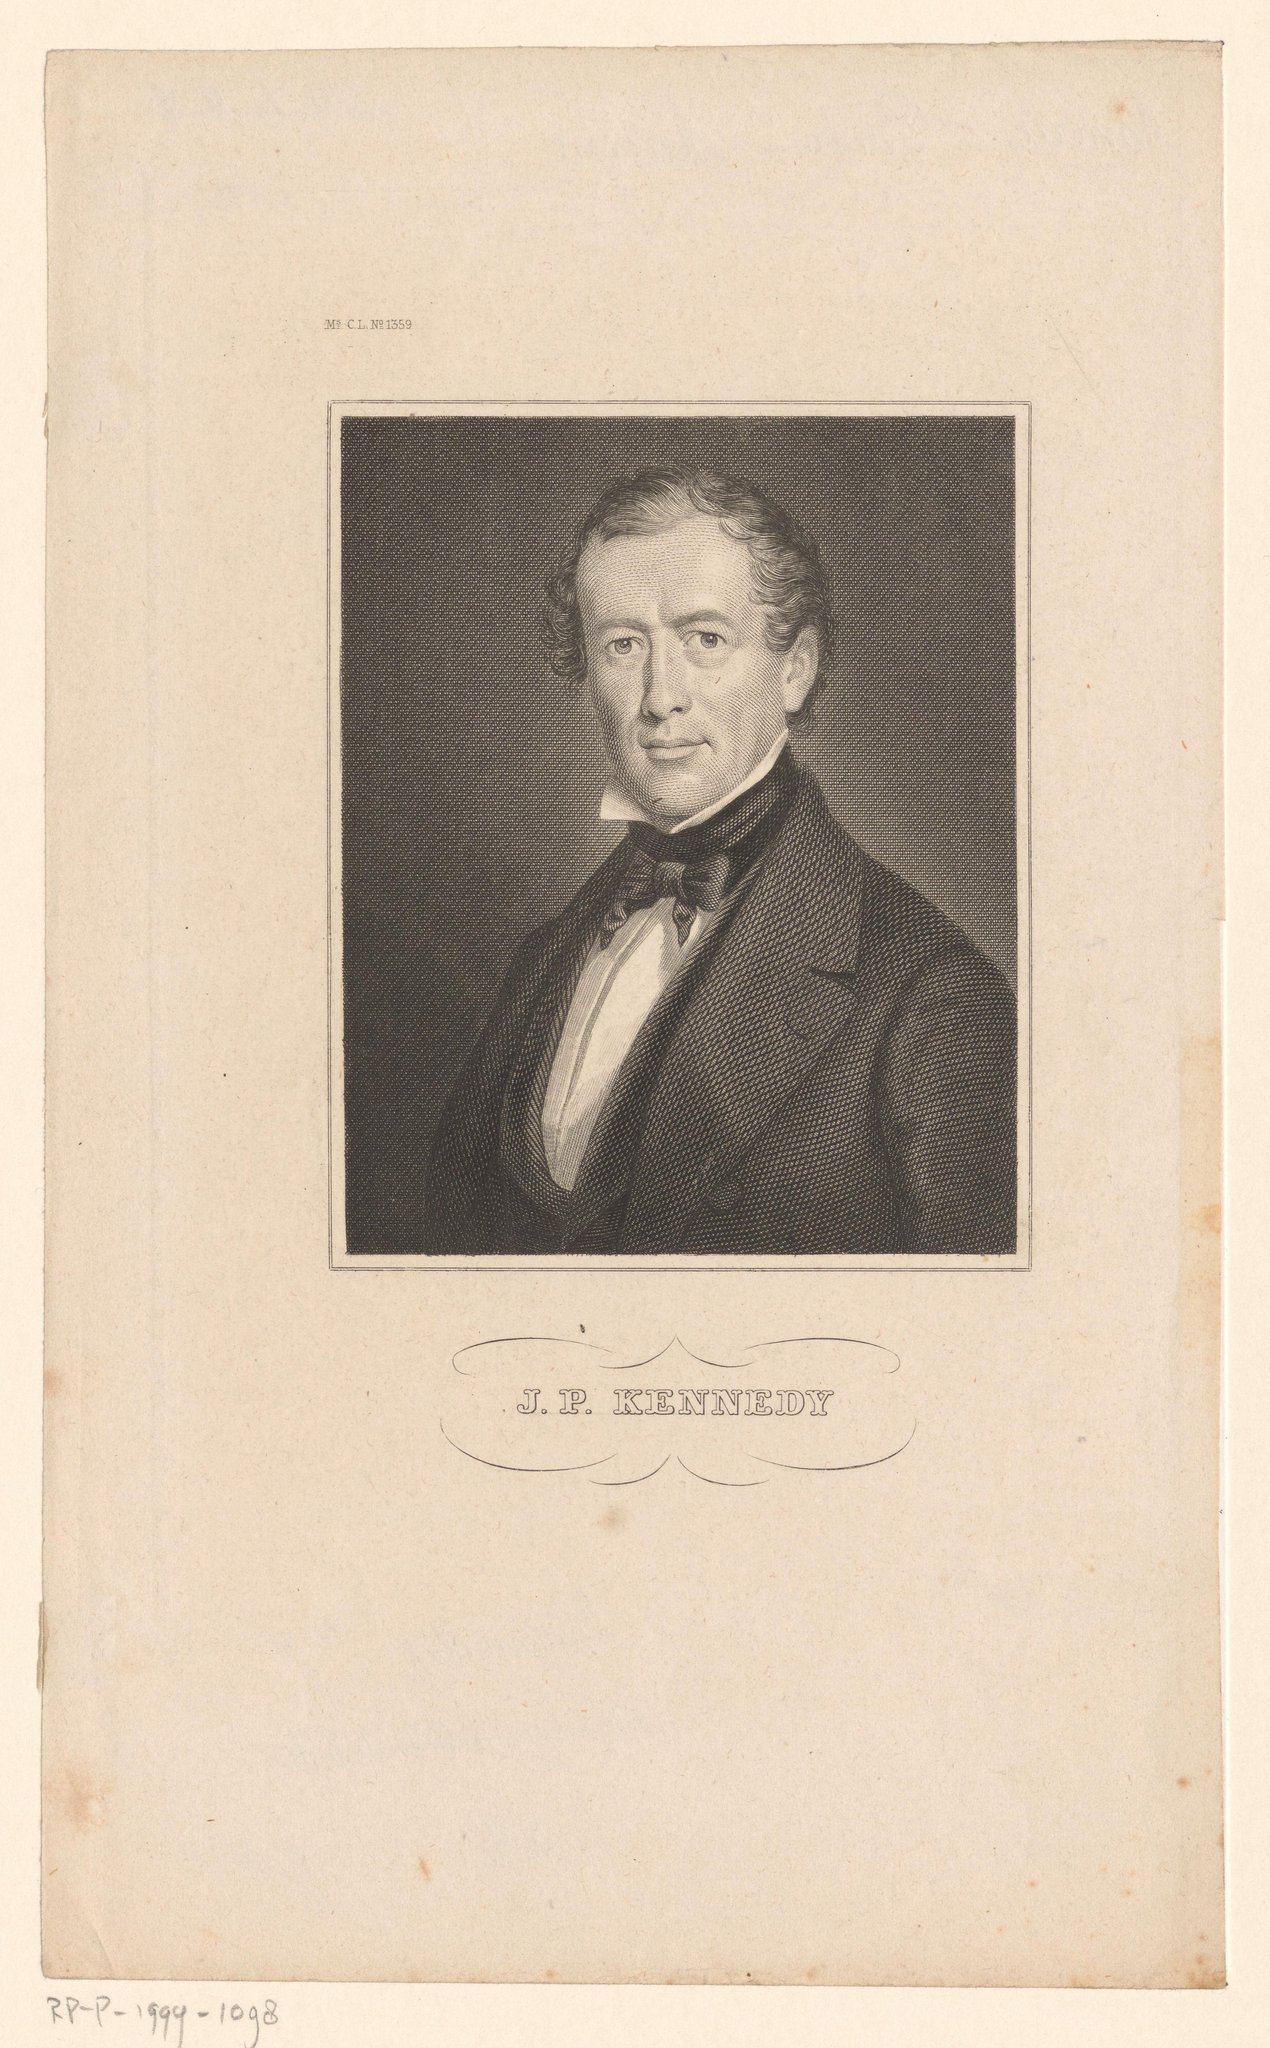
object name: print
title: Portret van John Pitt Kennedy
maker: Anonymous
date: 1844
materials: paper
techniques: engraving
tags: historical persons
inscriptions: collector's mark: Lugt 2760, collector's mark: Lugt 2228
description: Prent mogelijk uit: Meyer, Joseph. Neues Conversations-Lexikon für die gebildeten Stände. Hildburghausen: Bibliographisches Institut, 1844.